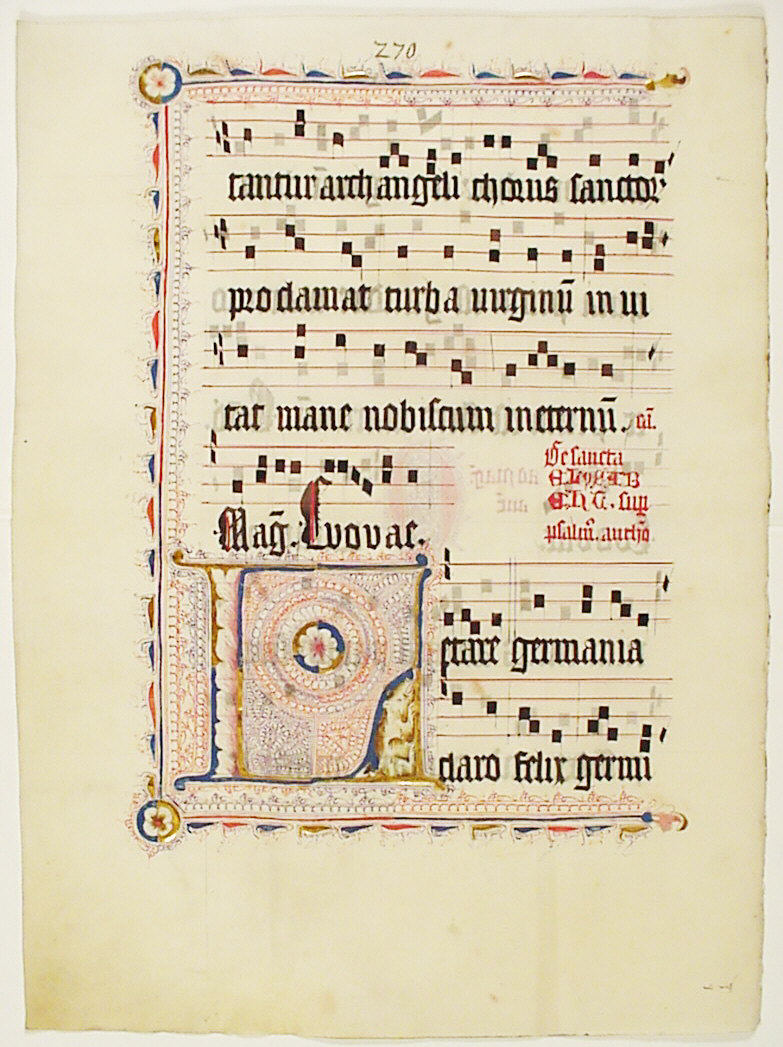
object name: antiphonary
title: Manuscript Leaf with Initial L, from an Antiphonary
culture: german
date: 1426-1450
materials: ink, metal leaf, parchment, paint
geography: germany